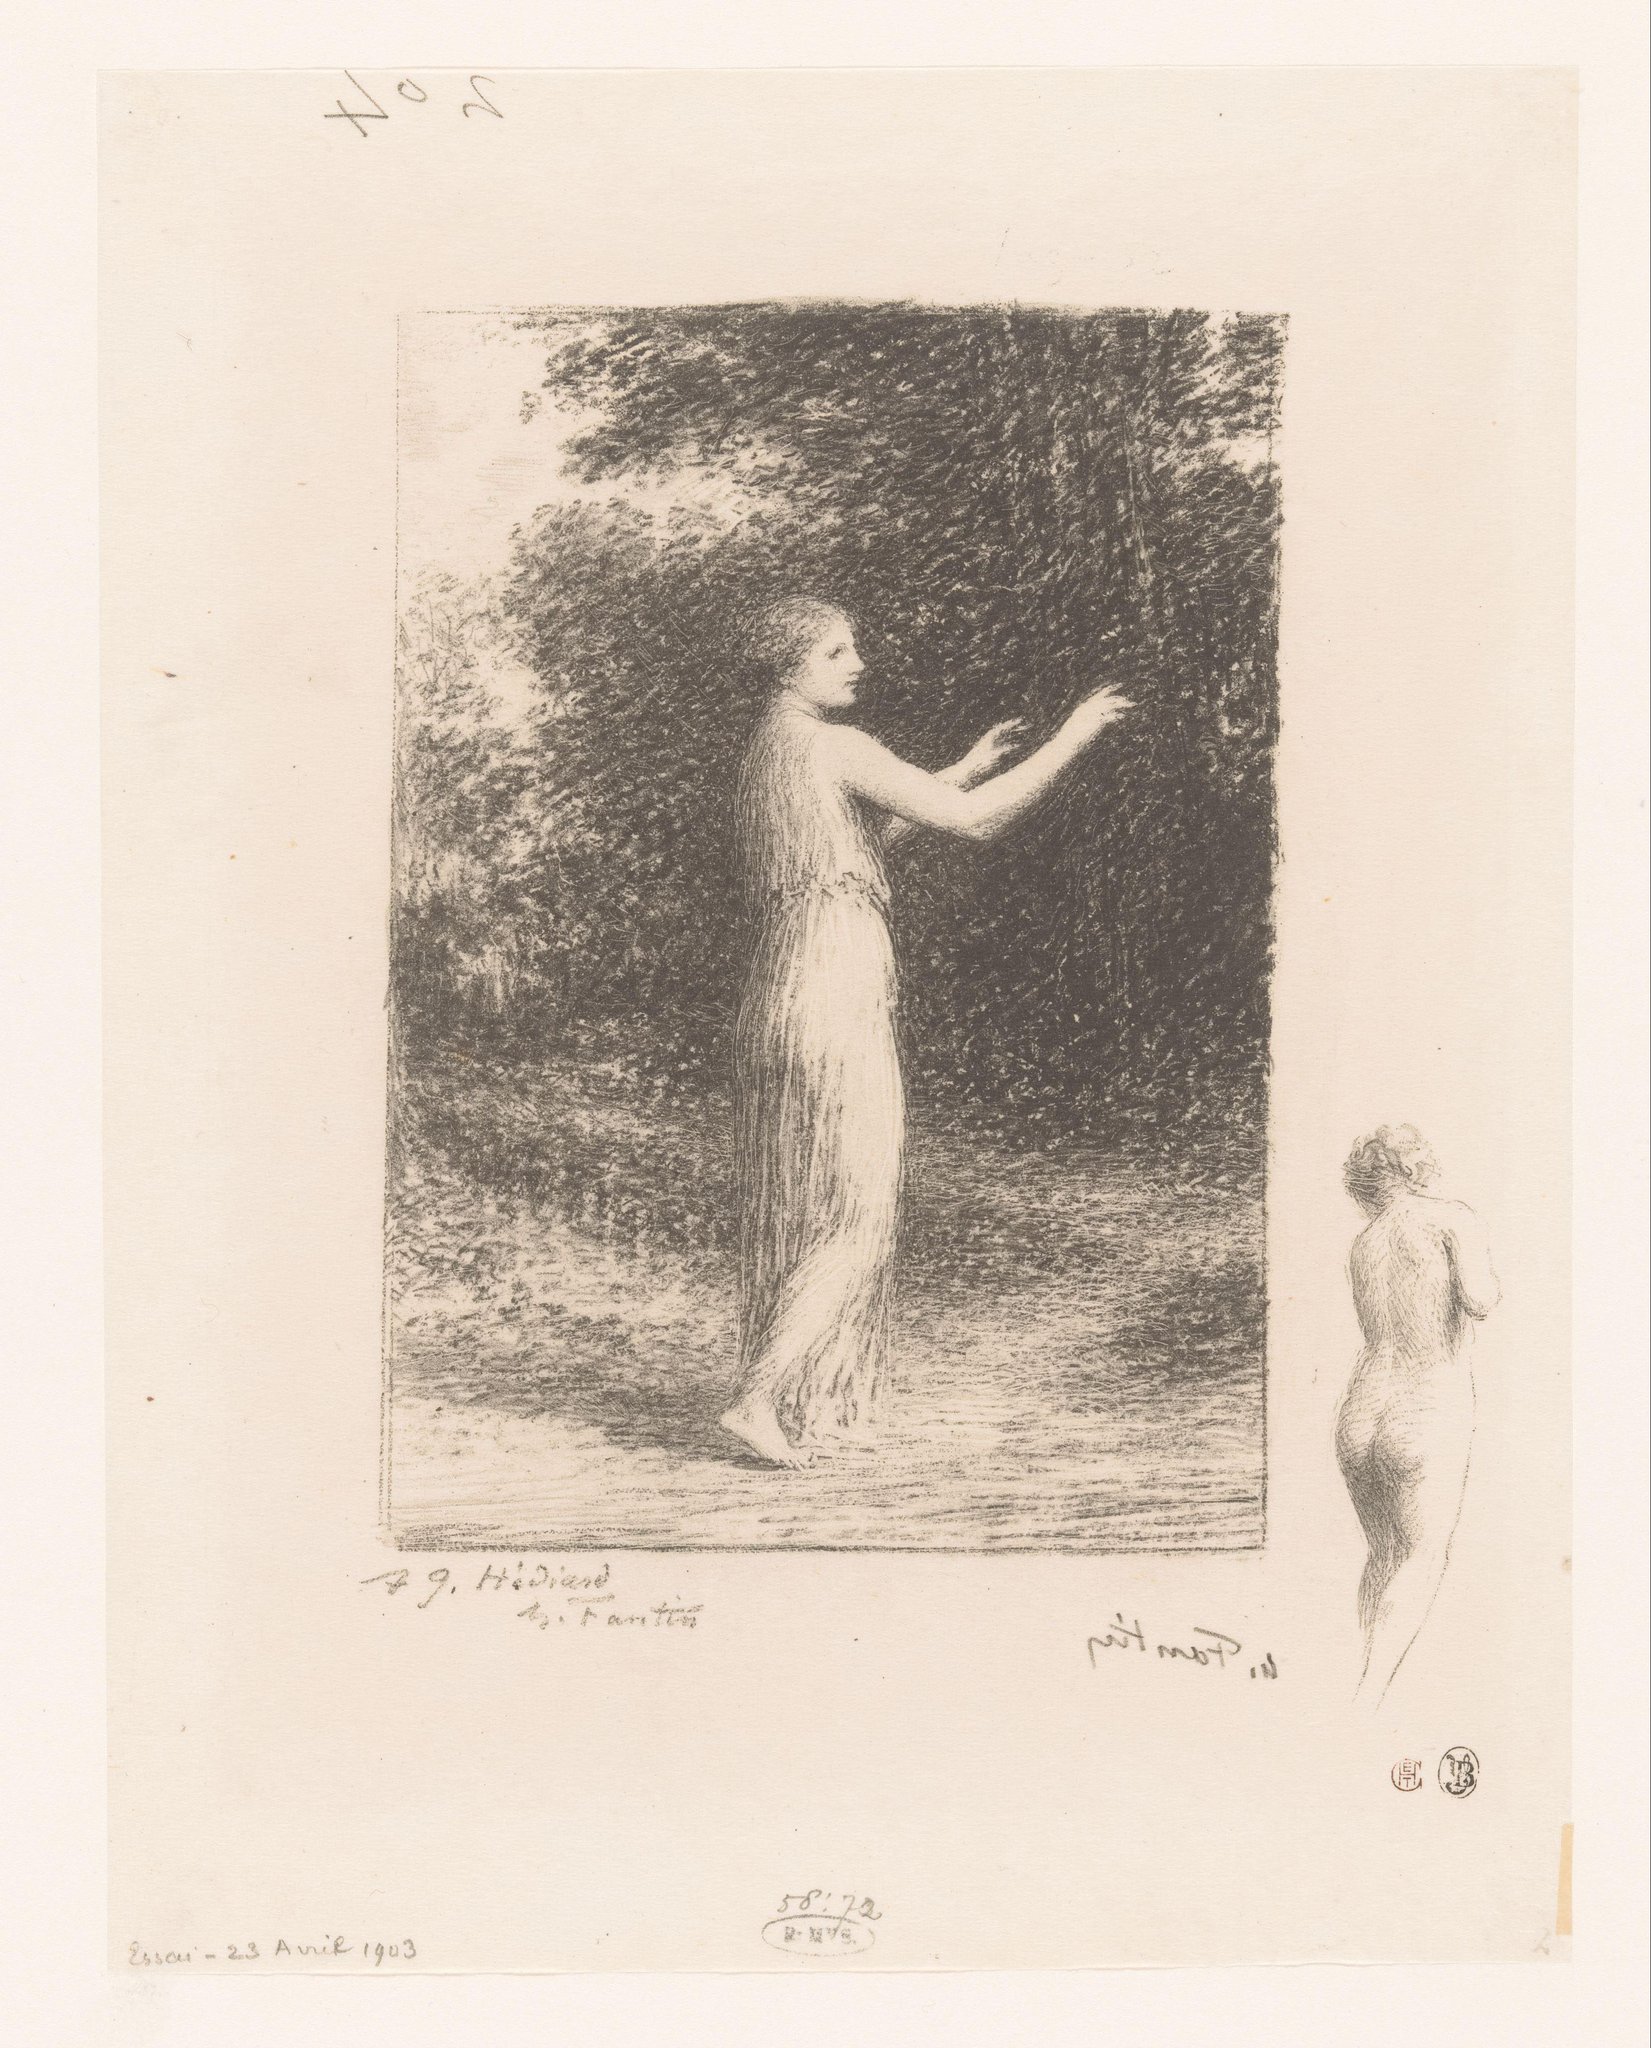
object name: print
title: Illustrations pour les Poésies d'André Chénier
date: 1903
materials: paper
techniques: lithography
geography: paris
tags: adolescent, young woman, maiden, single named nymphs, walking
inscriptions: collector's mark: Lugt 533b, collector's mark: Lugt 2228a, collector's mark: Lugt 421, annotation: ‘Essai - 23 Avril 1903’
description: Illustratie bij het gedicht Le Mendiant van André Chénier, specifiek de verzen: La fille de Lycus, vierge aux cheveux dorés, Sous les monts Achéens, non loin de Crénée, Errait à l'ombre, aux bords du faible et pur Crathis.